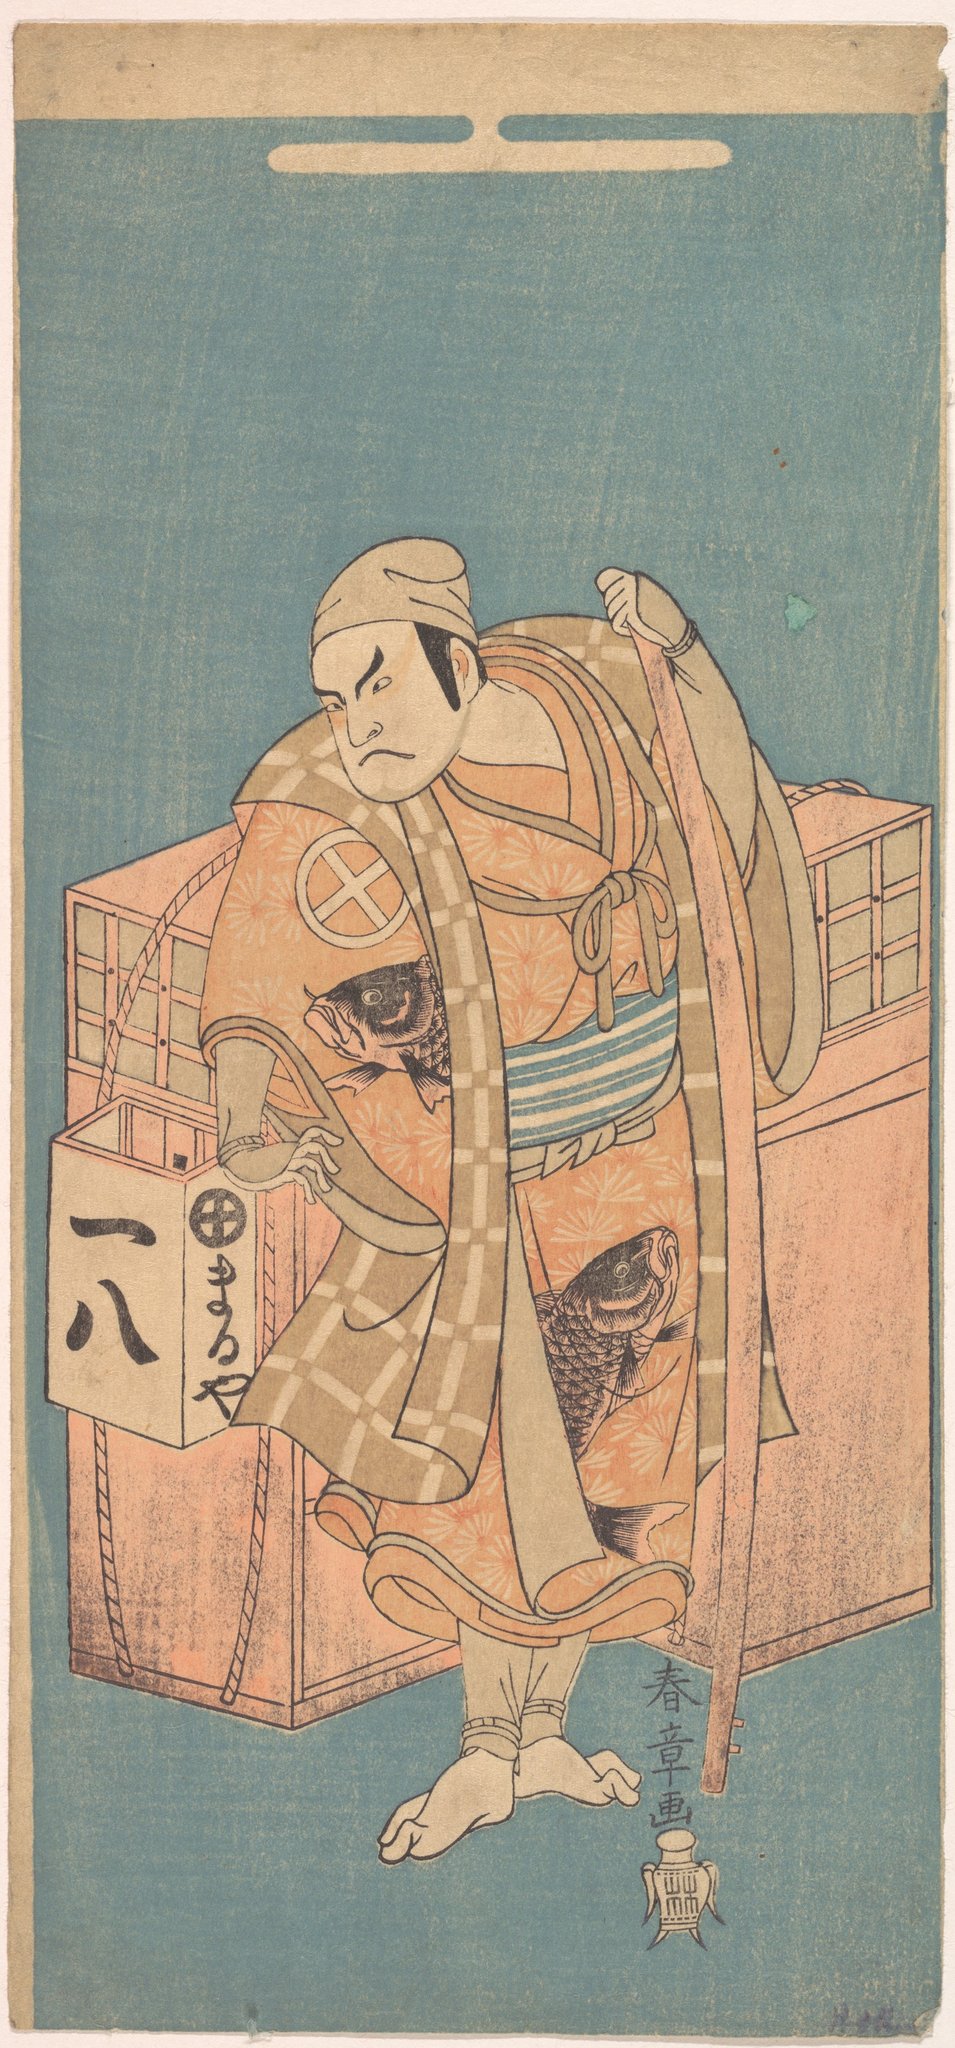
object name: woodblock print nishiki e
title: The Actor Otani Hiroji I 1699–1747 in the Role of a Fish–vendor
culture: japanese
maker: katsukawa shunshō 勝川春章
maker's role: artist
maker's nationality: japanese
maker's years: 1726-1792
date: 1726-1792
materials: ink, paper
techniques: nishiki e, woodblock print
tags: men,fish,actors